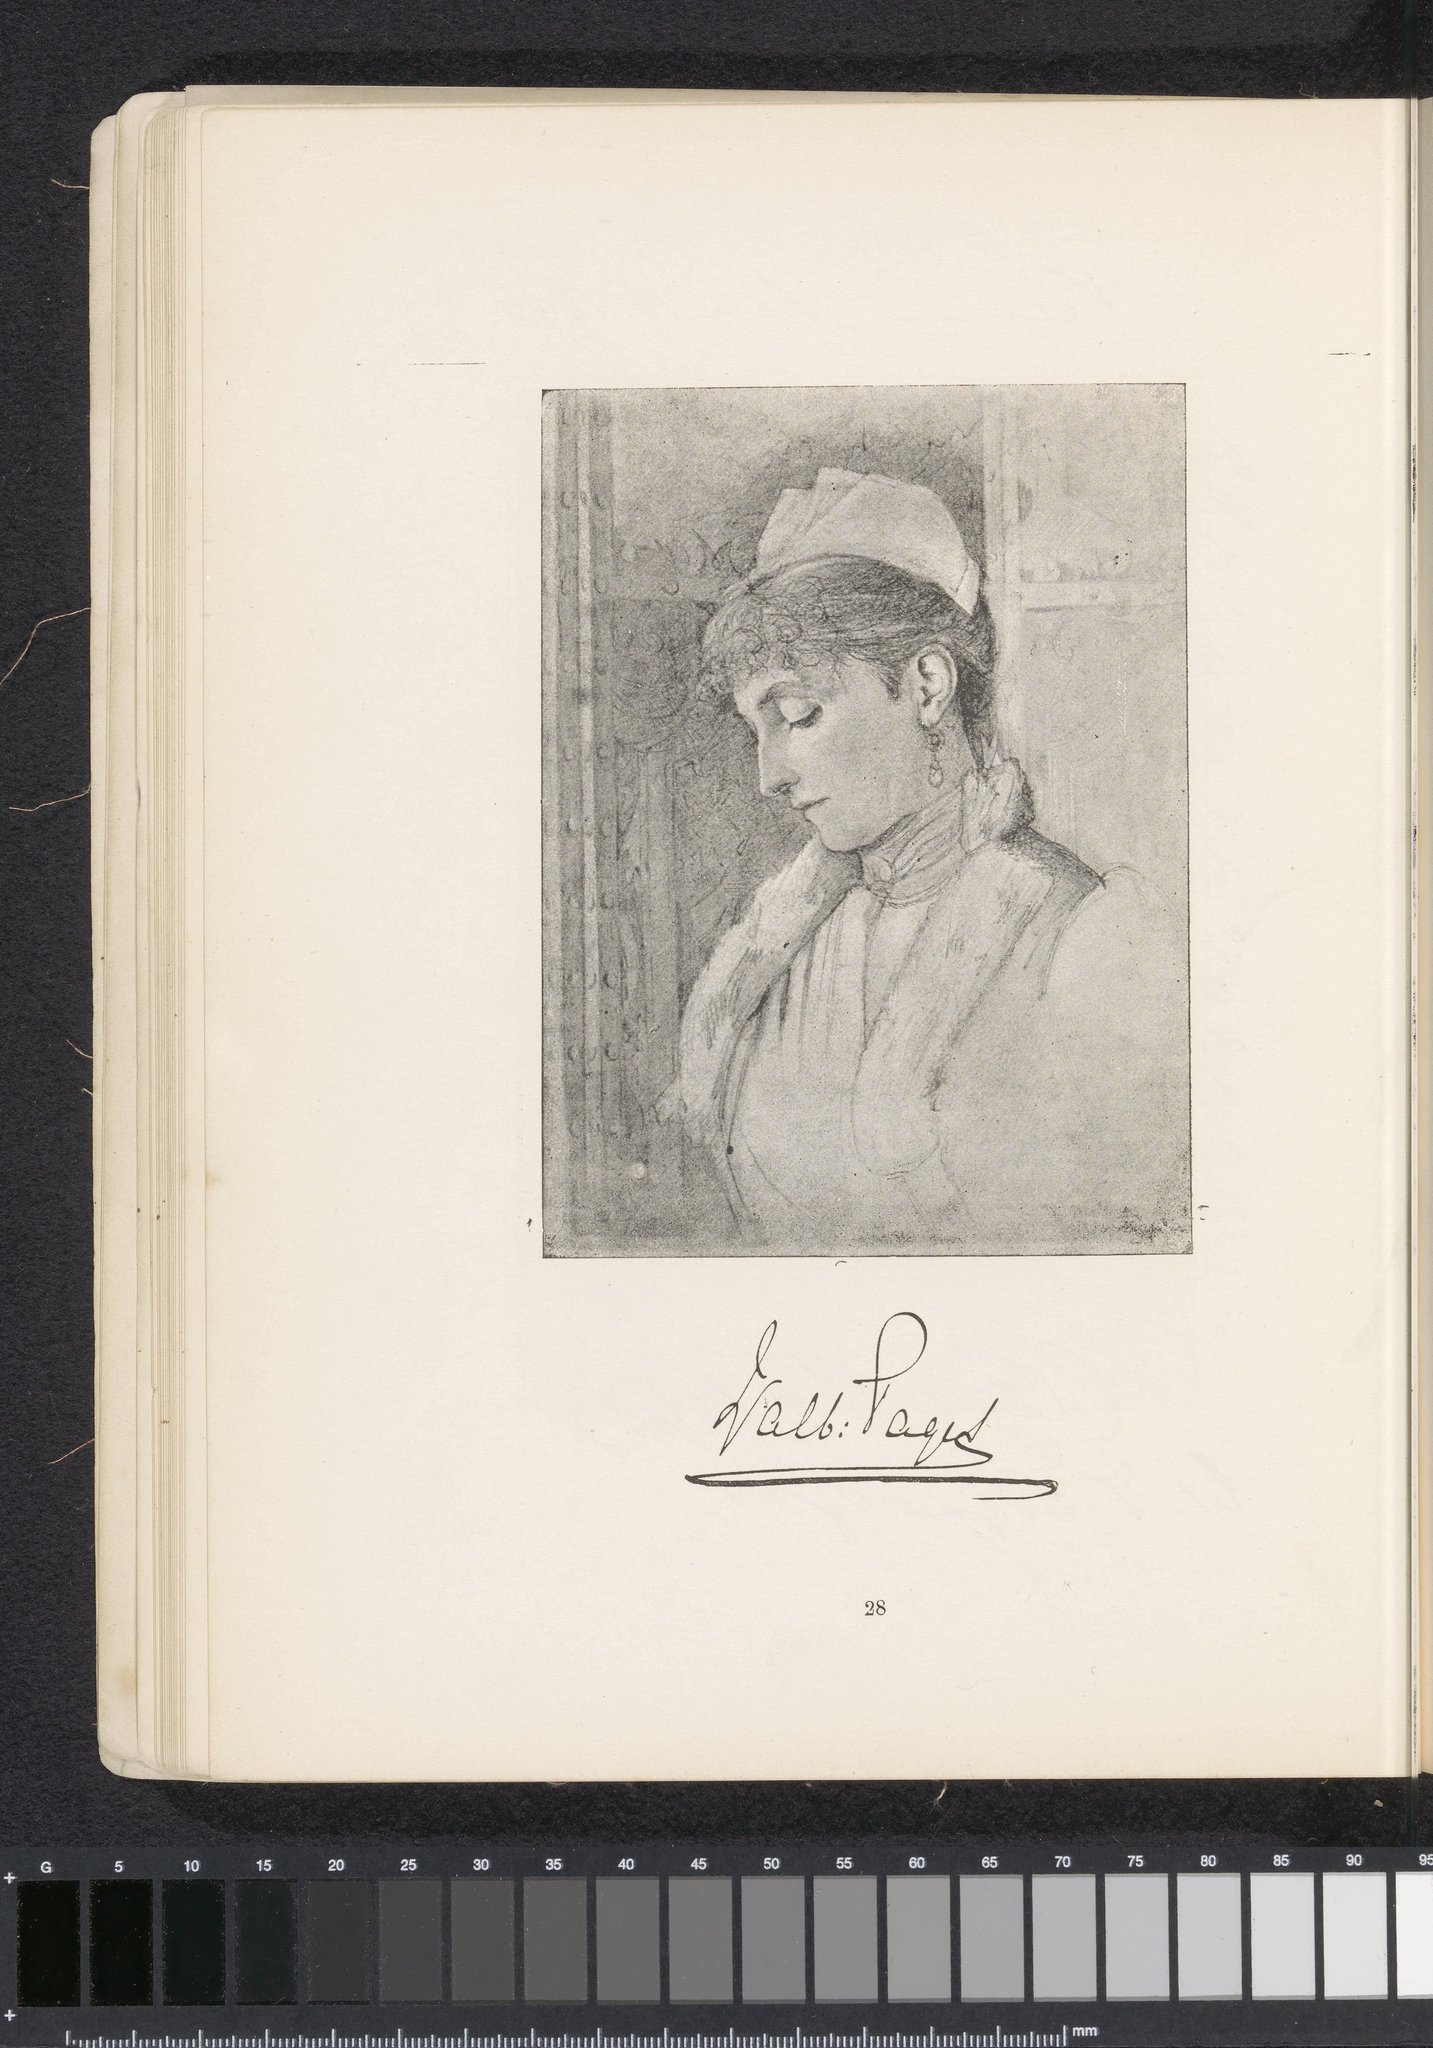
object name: reproduction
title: Fotoreproductie van een tekening, voorstellende een portret van Lady Paget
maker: Anonymous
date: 1881-1891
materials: paper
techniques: autotype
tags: portrait of a writer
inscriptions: inscription